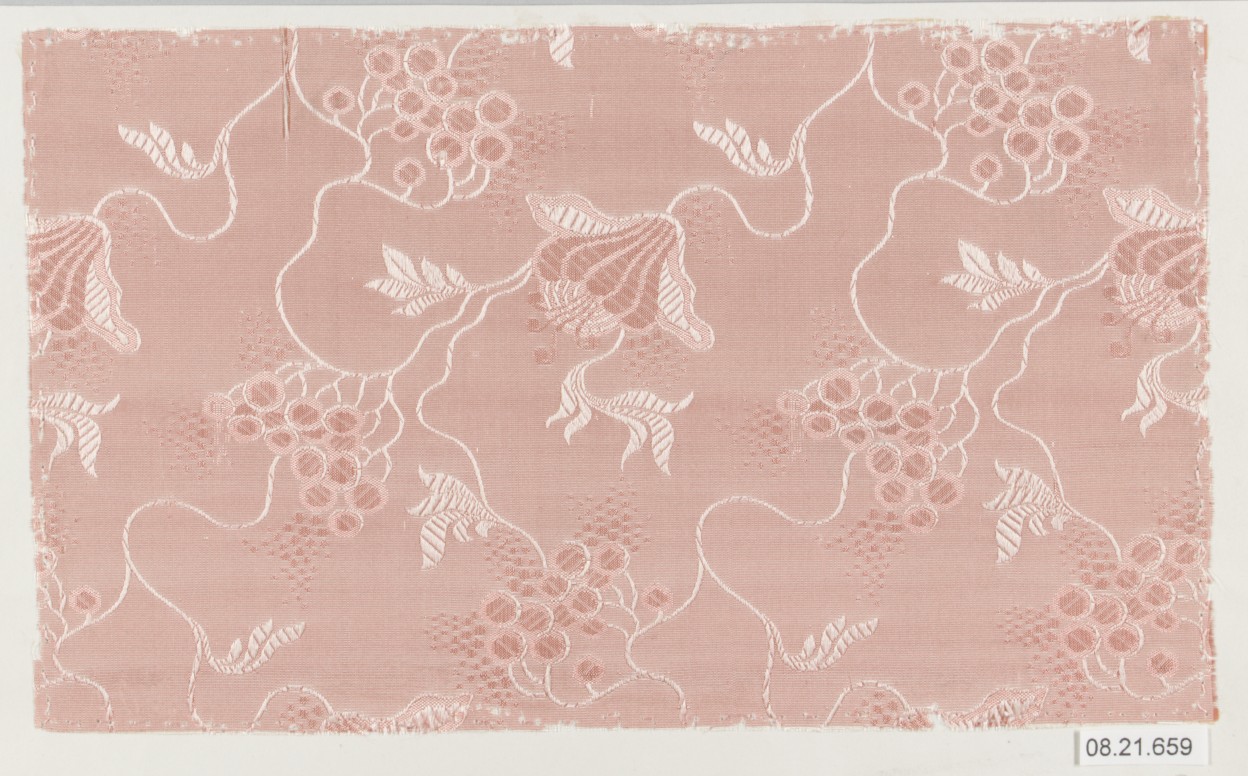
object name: textile sample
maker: Anonymous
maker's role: designer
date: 1900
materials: silk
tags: flowers